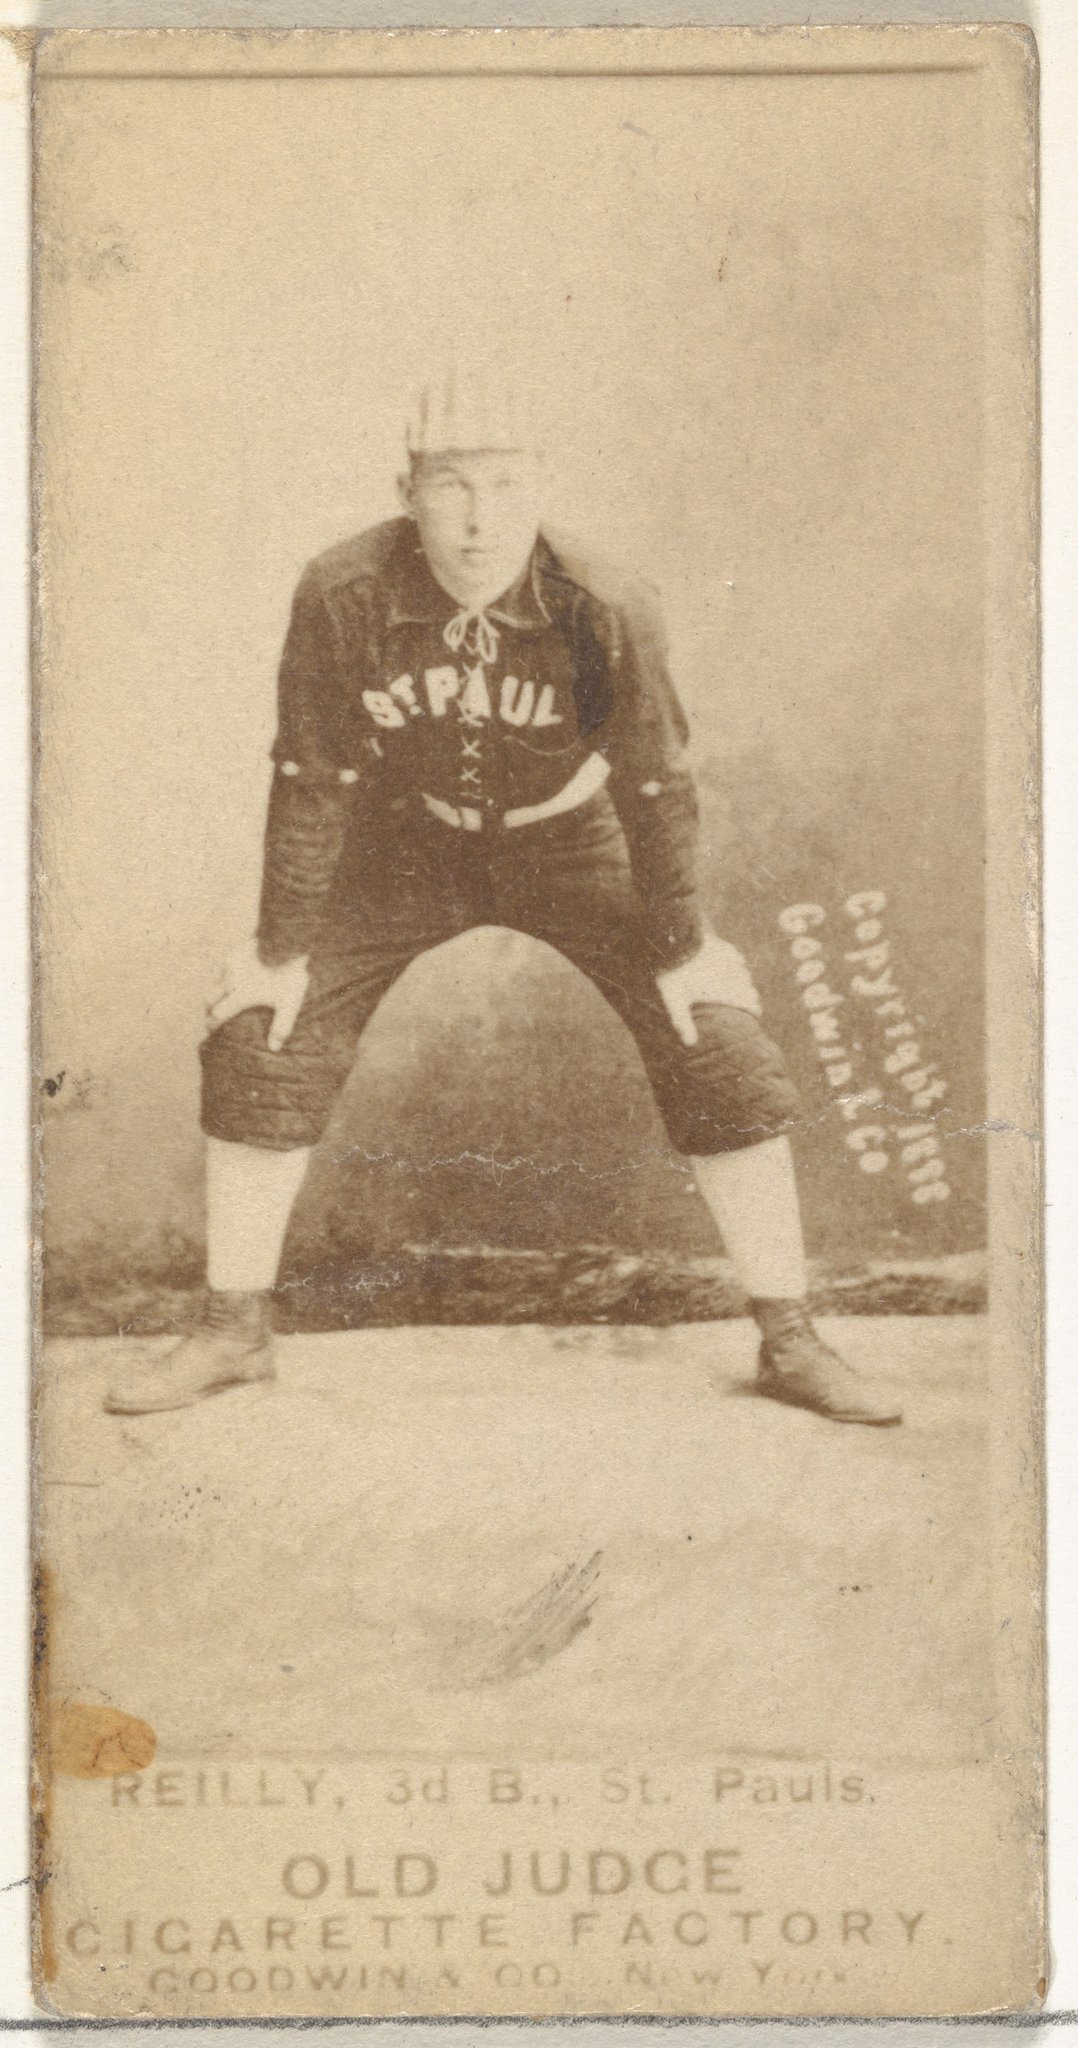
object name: baseball card, photograph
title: Charles Thomas "Charlie" Reilly, 3rd Base, St. Paul Apostles, from the Old Judge series (N172) for Old Judge Cigarettes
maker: goodwin & company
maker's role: publisher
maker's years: 1850-1950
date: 1888-1889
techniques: albumen silver print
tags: men,portraits,baseball,athletes